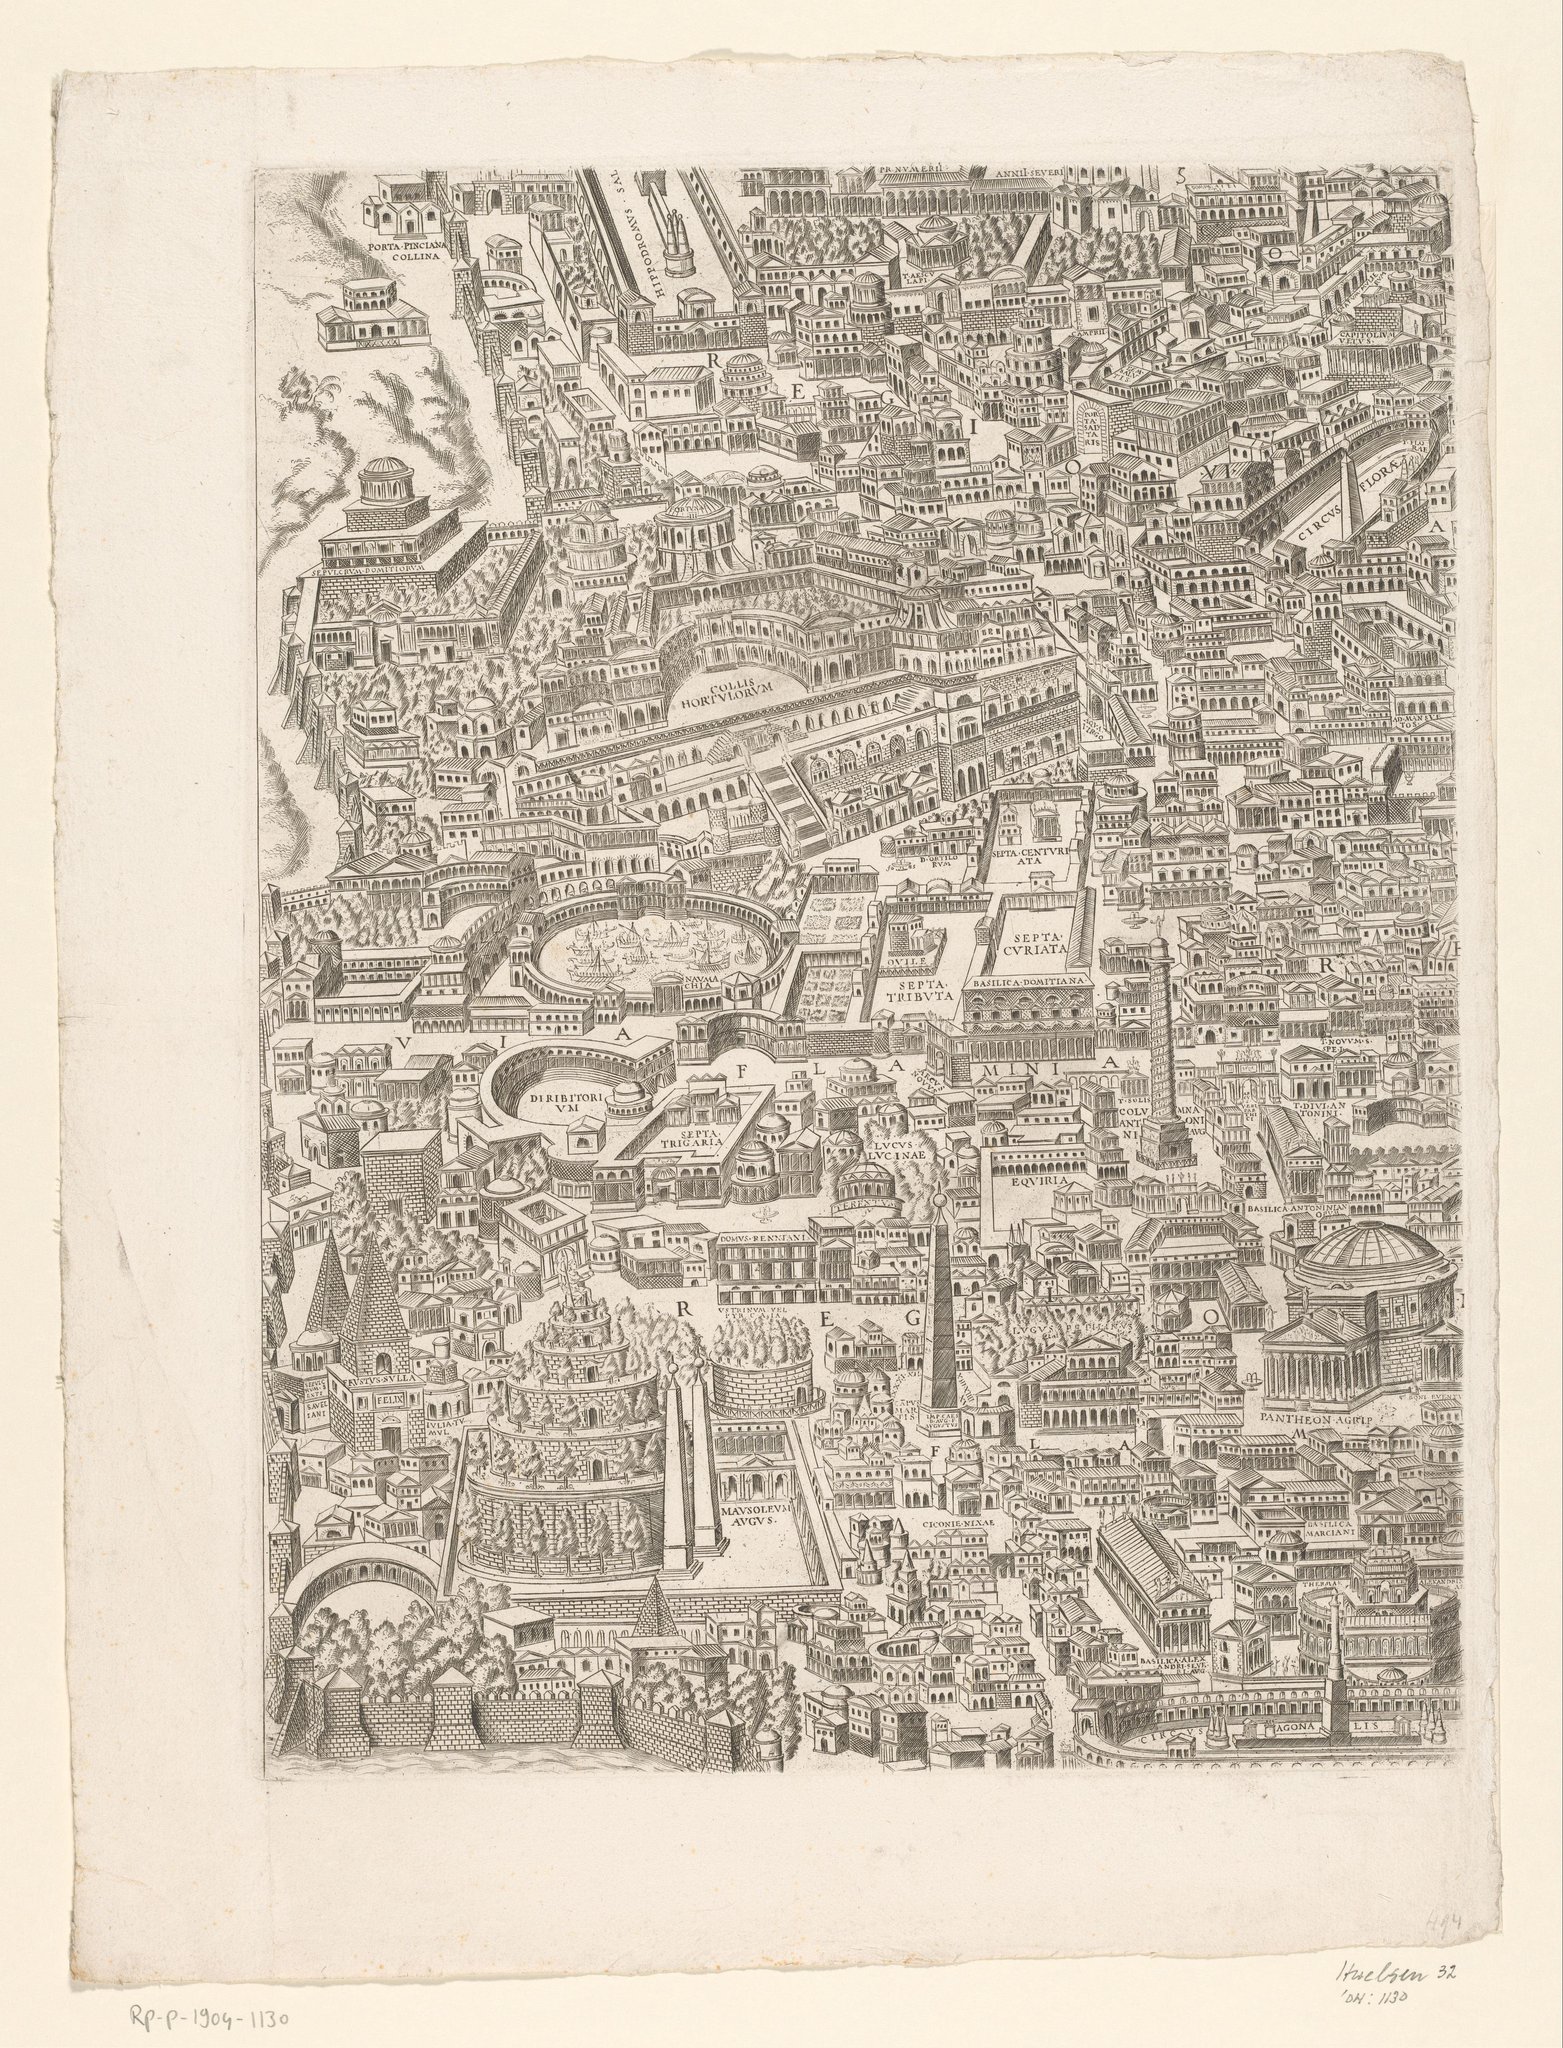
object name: area plan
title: Plattegrond van Rome in de Romeinse tijd (vijfde deel)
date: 1773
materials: paper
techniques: engraving, etching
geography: rome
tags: maps of cities, rome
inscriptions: collector's mark: Lugt 2228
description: Vijfde deel van een plattegrond van Rome in de Romeinse tijd, in vogelvluchtperspectief, bestaande uit twaalf delen. Rechtsboven genummerd: 5.